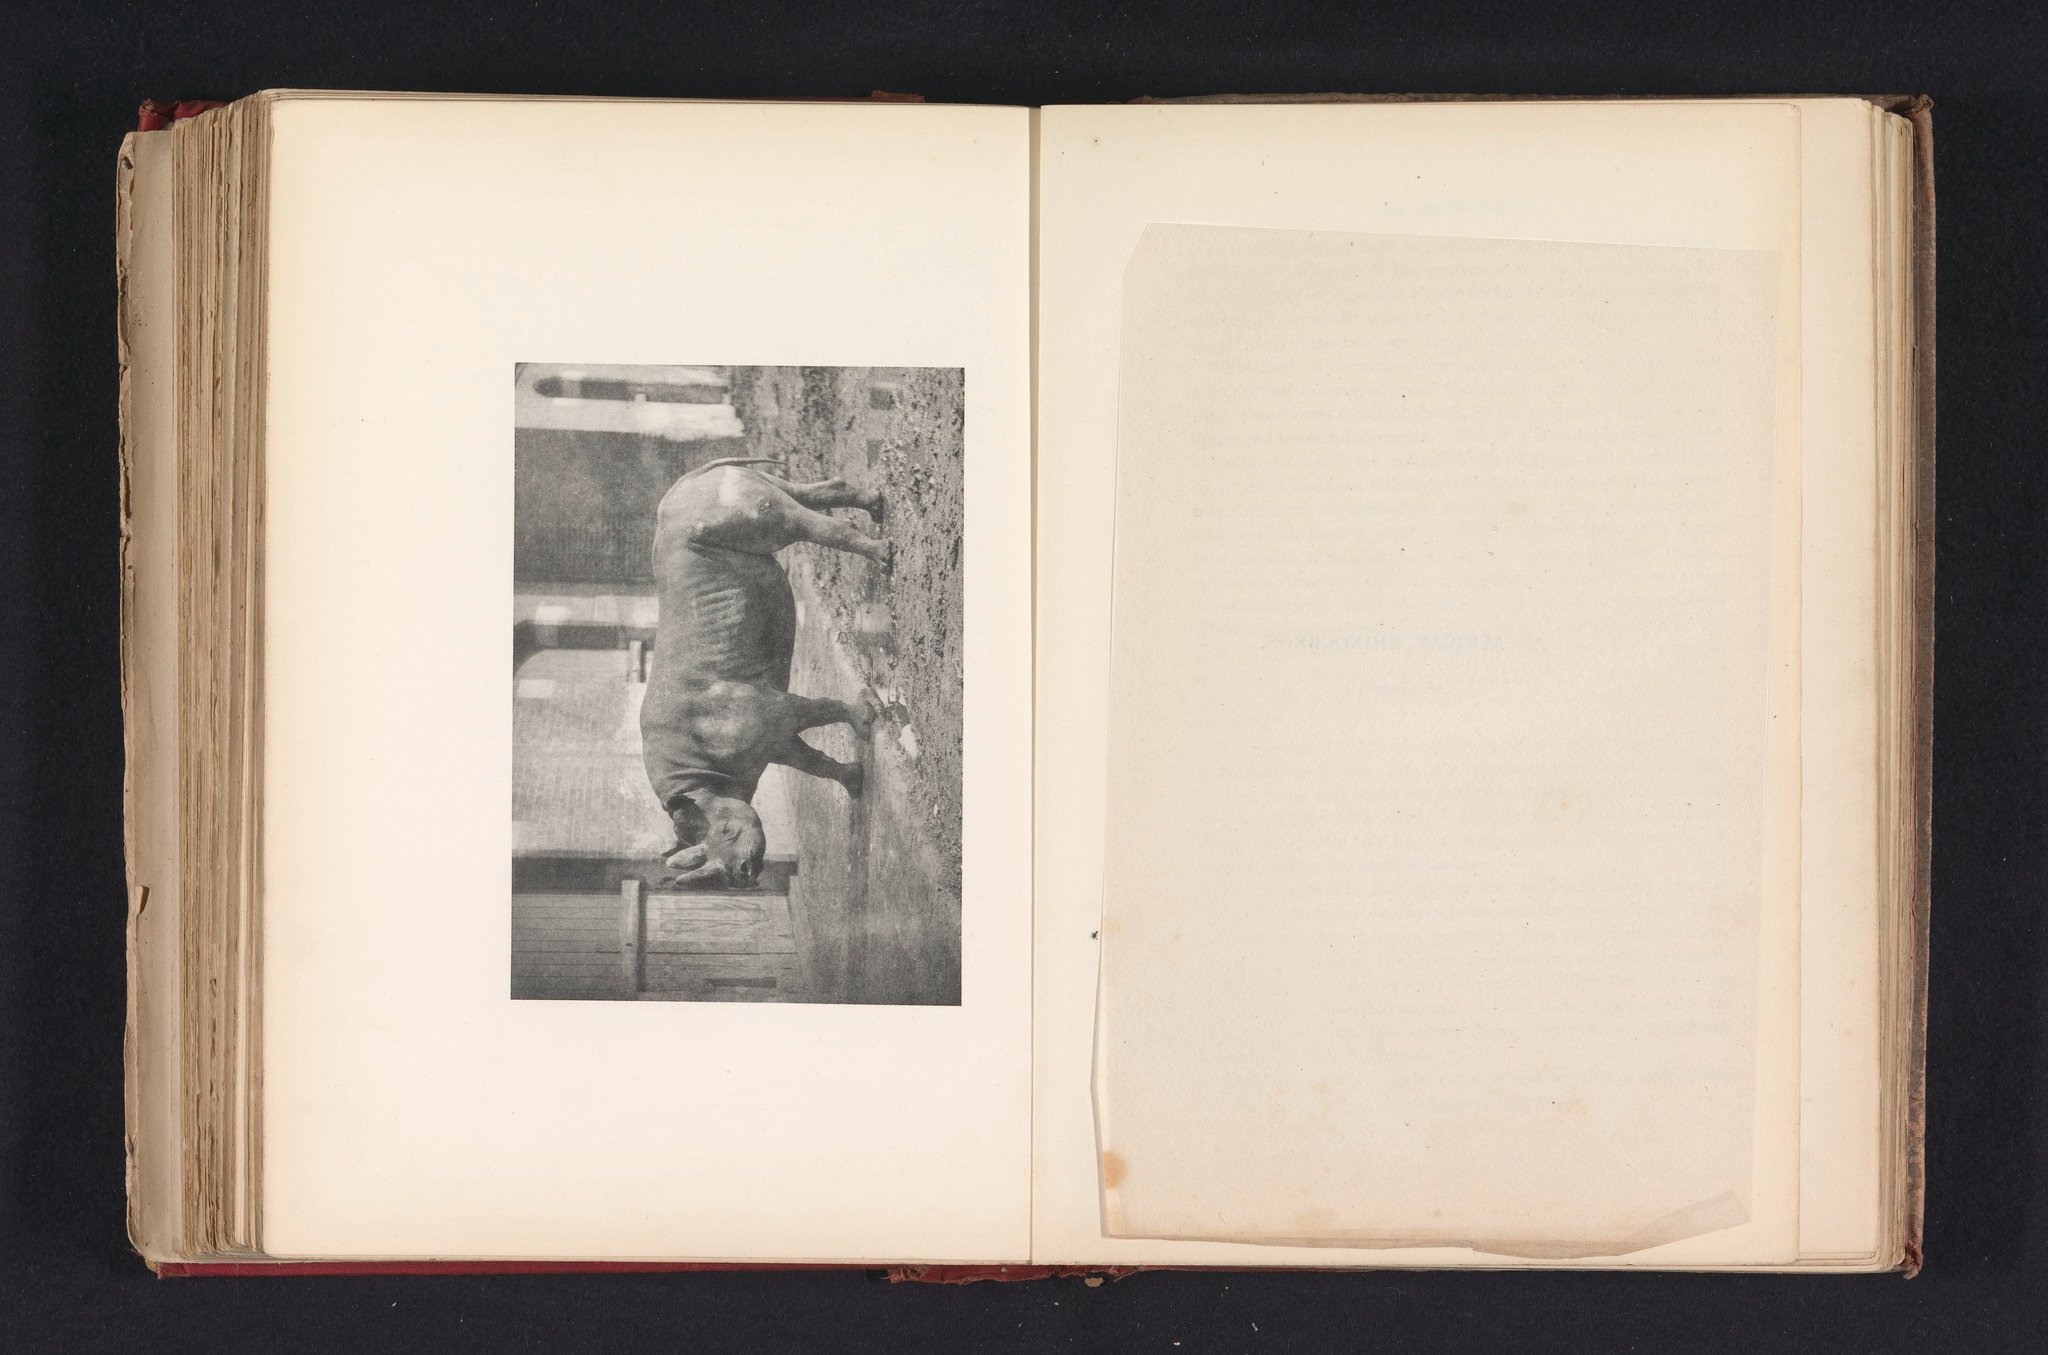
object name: photomechanical print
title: An African rhinoceros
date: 1876-1886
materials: paper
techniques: photograph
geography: paris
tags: hoofed animals: rhinoceros